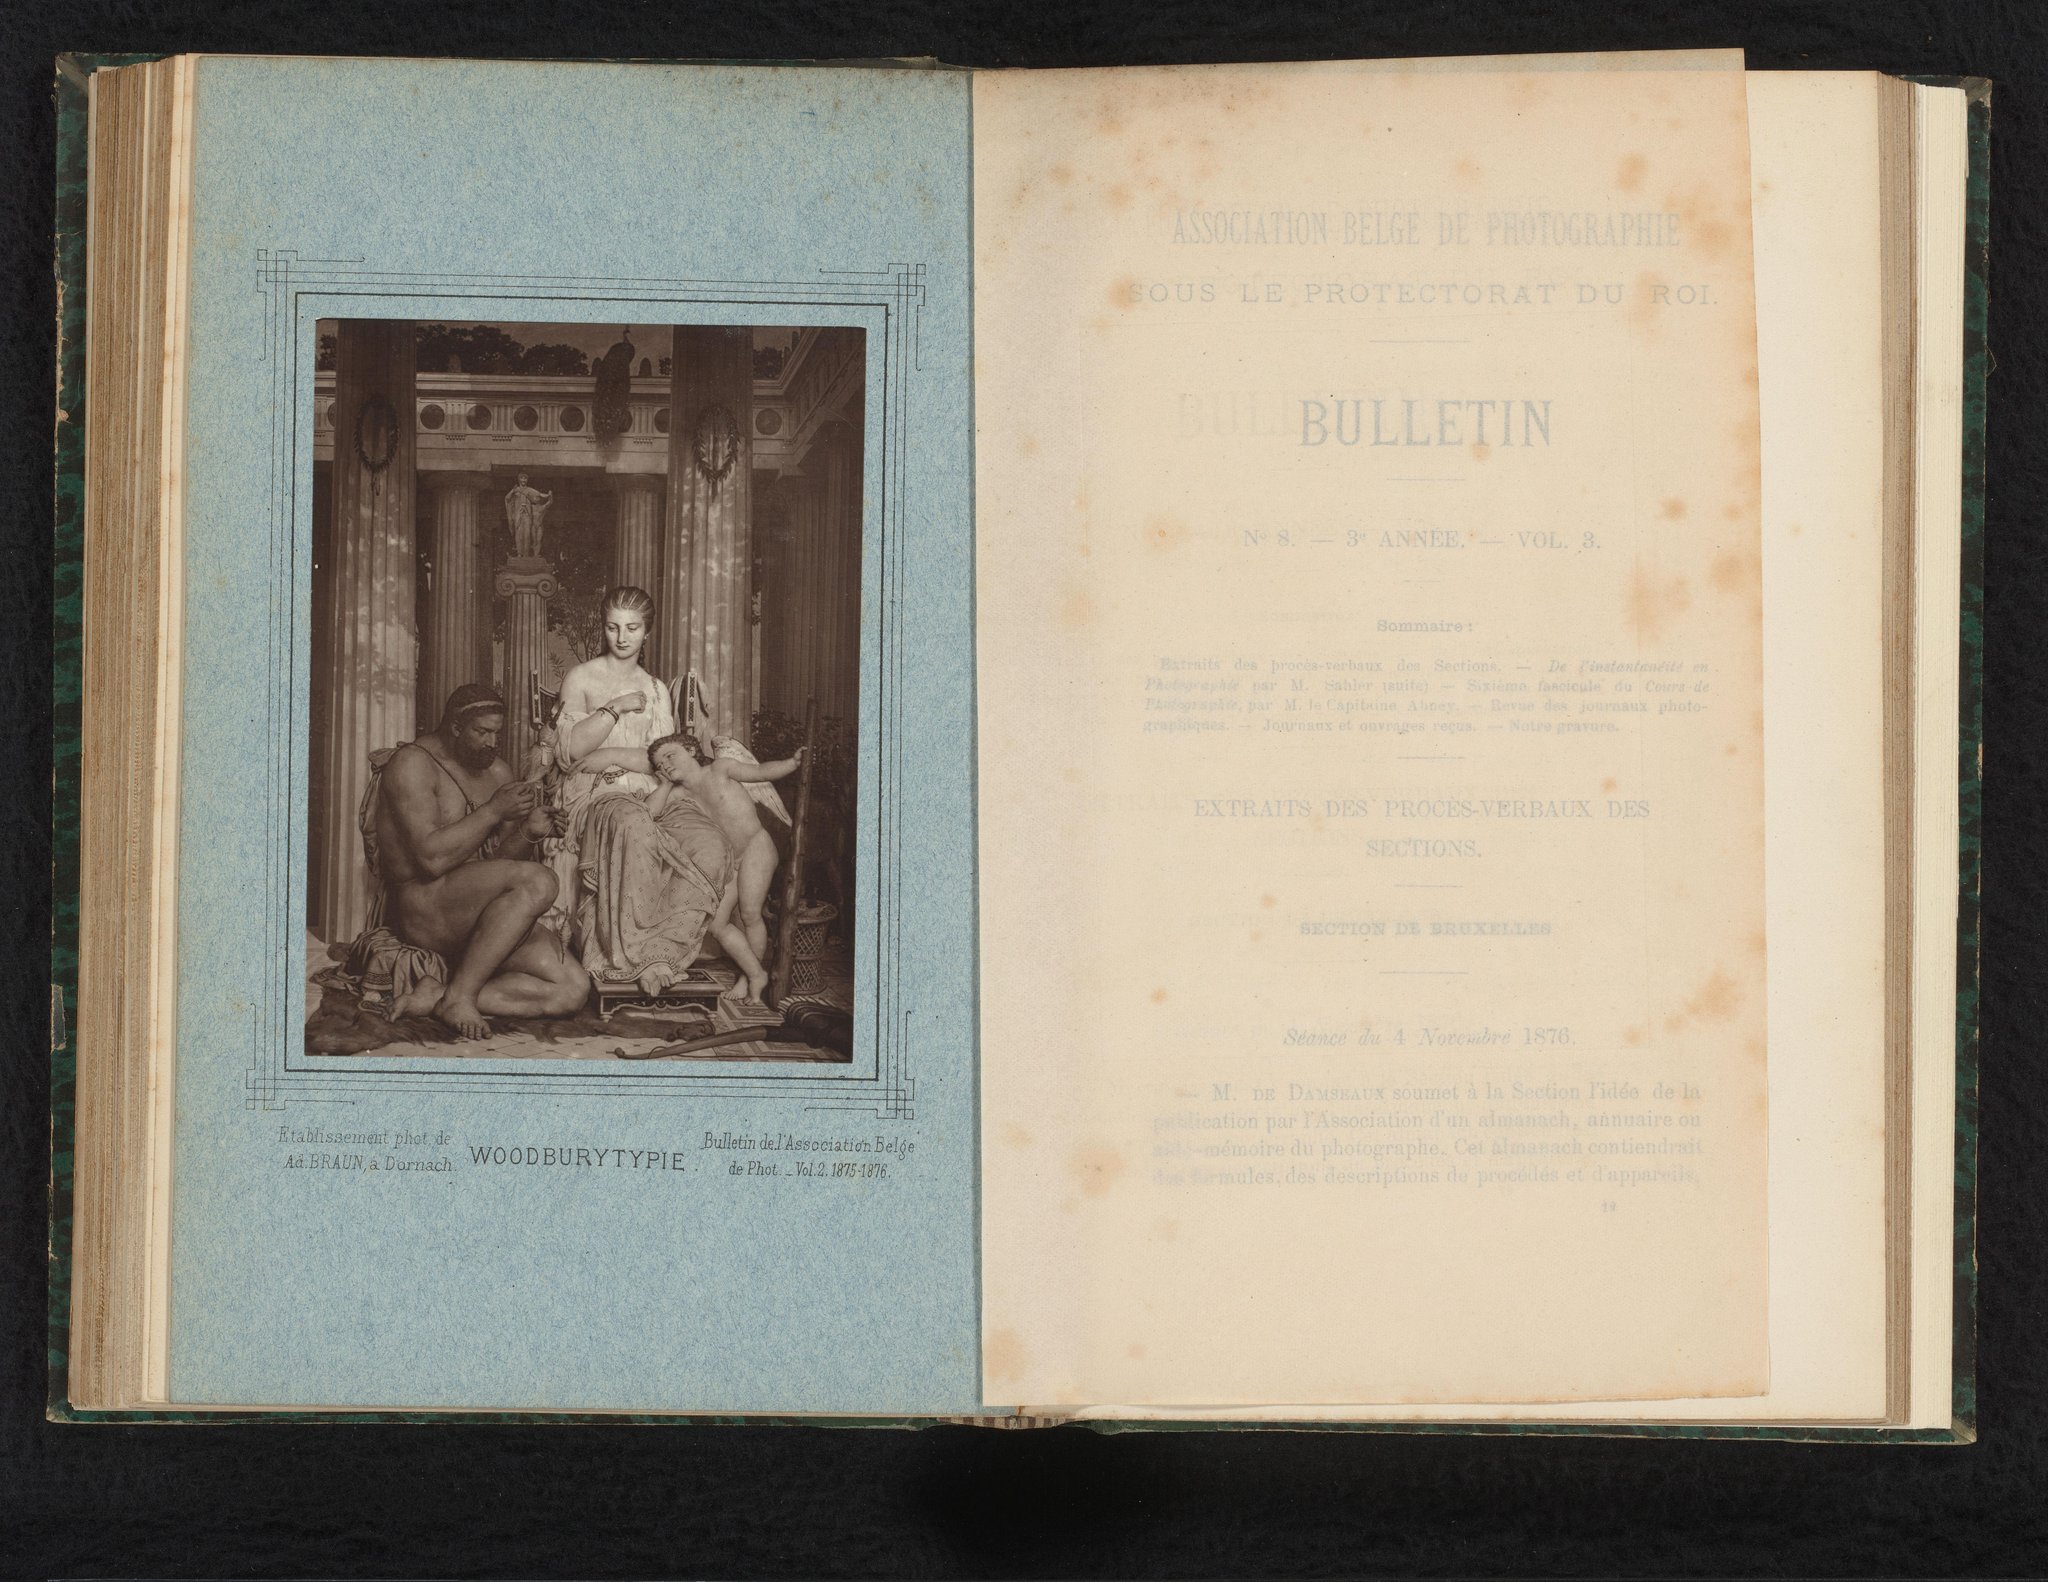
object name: photomechanical print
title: Hercule filant aux pieds d'Omphale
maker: charles gleyre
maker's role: painter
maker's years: 1806-1874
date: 1876-1877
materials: cardboard, paper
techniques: woodburytype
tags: hercules in love with omphale; the hero is set to spin wool or to do other women's work among the servants, while omphale wears his lion's skin and wields his club and bow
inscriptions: inscription: ‘Woodburytypie’